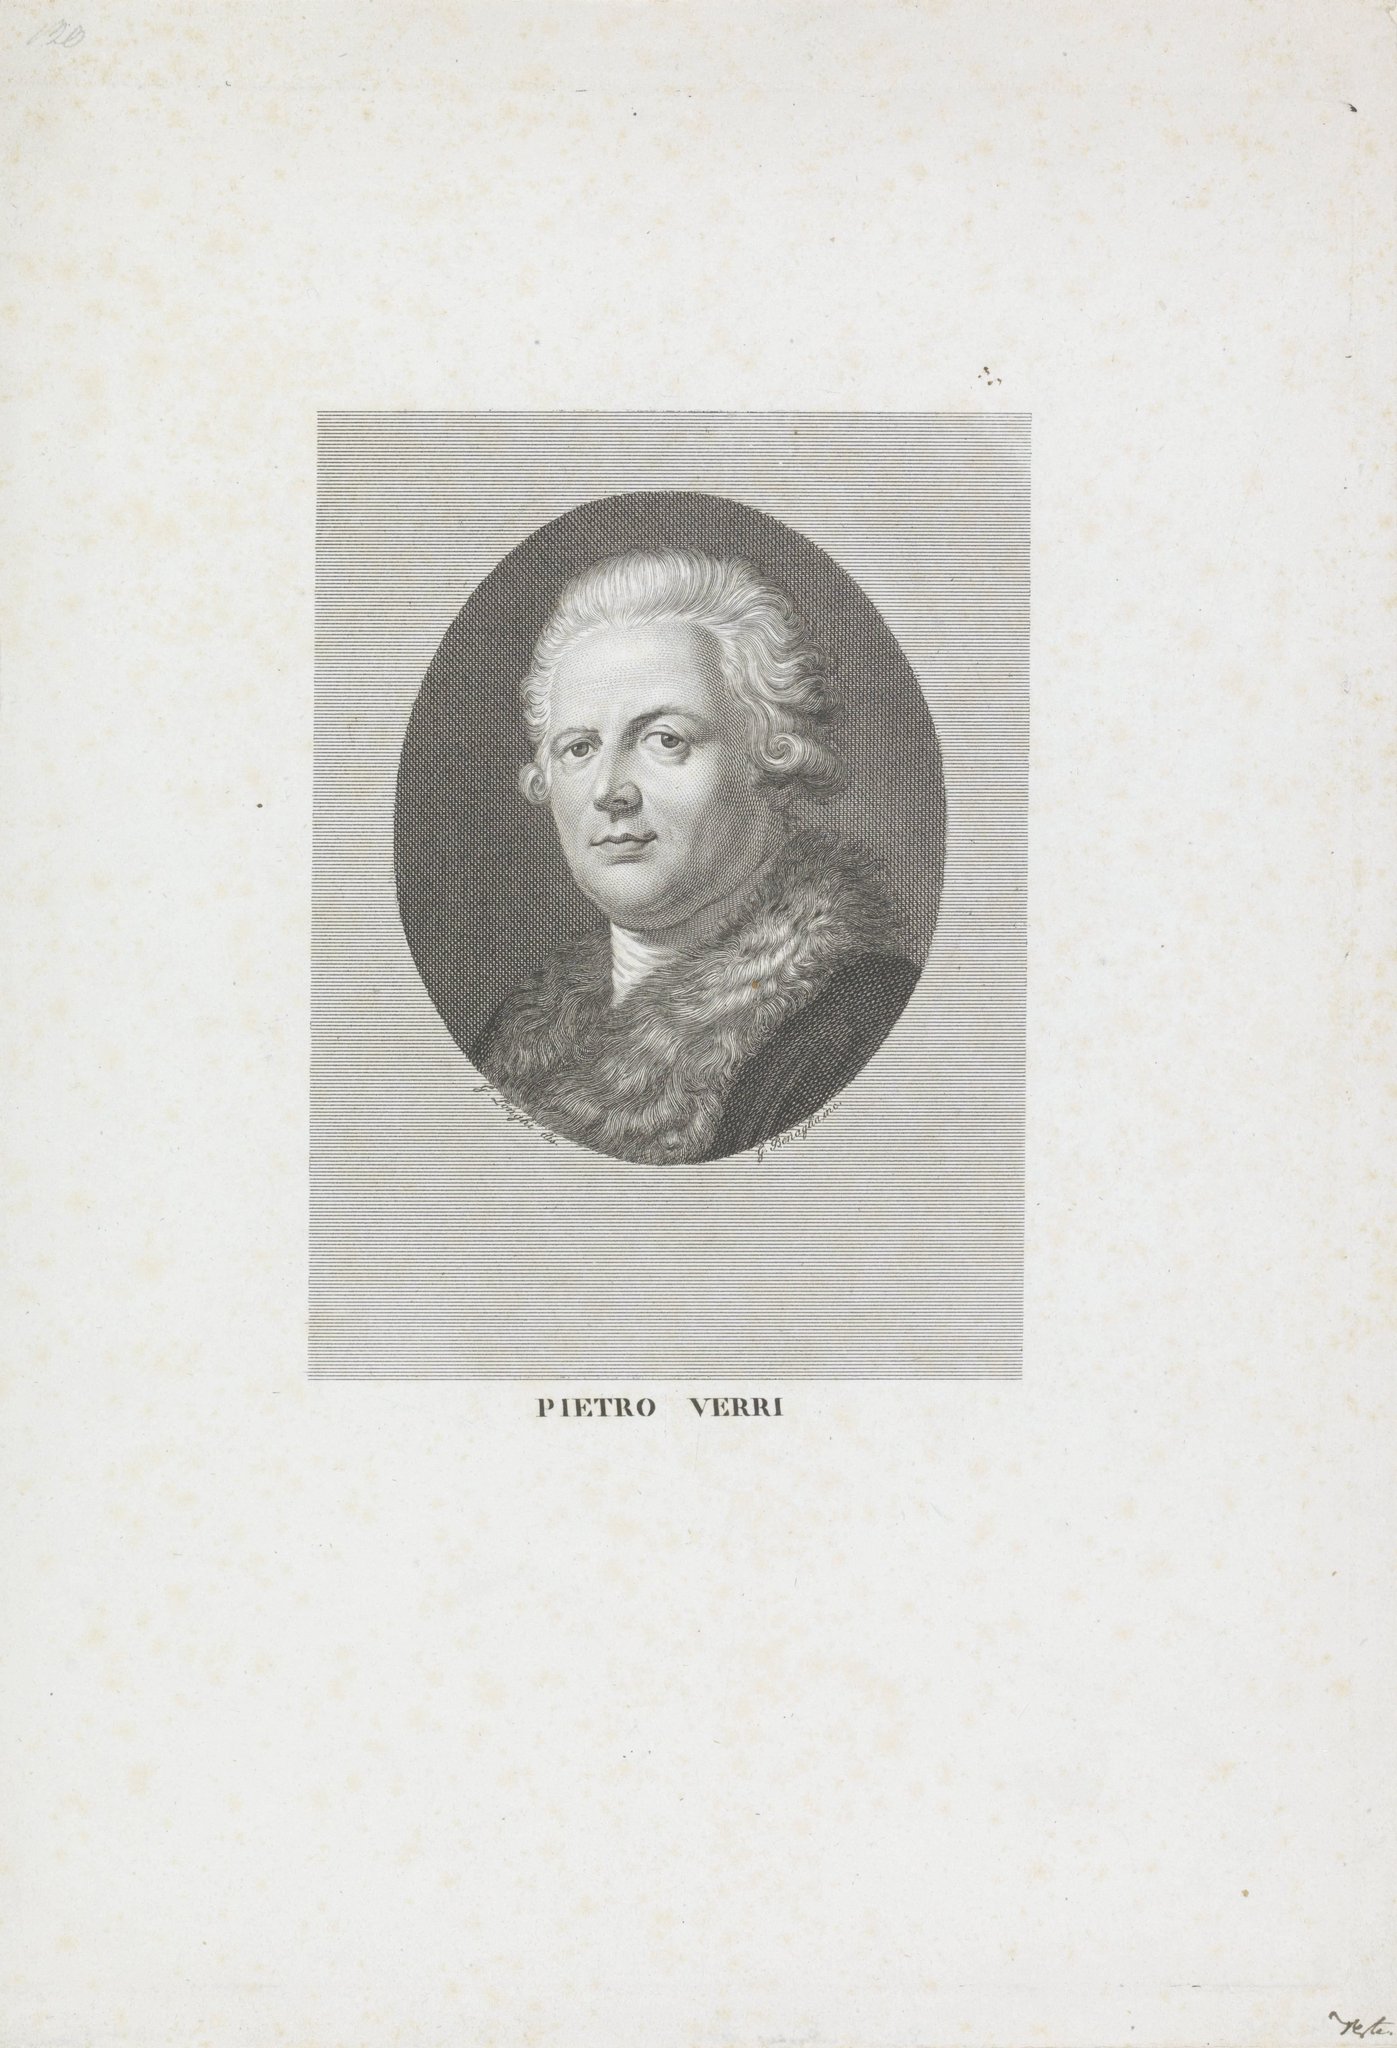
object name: print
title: Portret van Pietro Verri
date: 1806-1830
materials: paper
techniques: engraving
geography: italy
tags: historical persons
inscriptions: collector's mark: Lugt 2228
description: Deze prent maakt deel uit van een reeks portretprenten van onbekende omvang. De reeks is in meerdere staten uitgegeven. De eerste staat met enkel het portret in ovaal. Een tweede staat met naam van de geportretteerde in holle letters onder de voorstelling. Een derde staat met de naam van de geportretteerde in gevulde letters onder de voorstelling. En een vierde staat met een rechthoekig kader rondom het ovale portret.